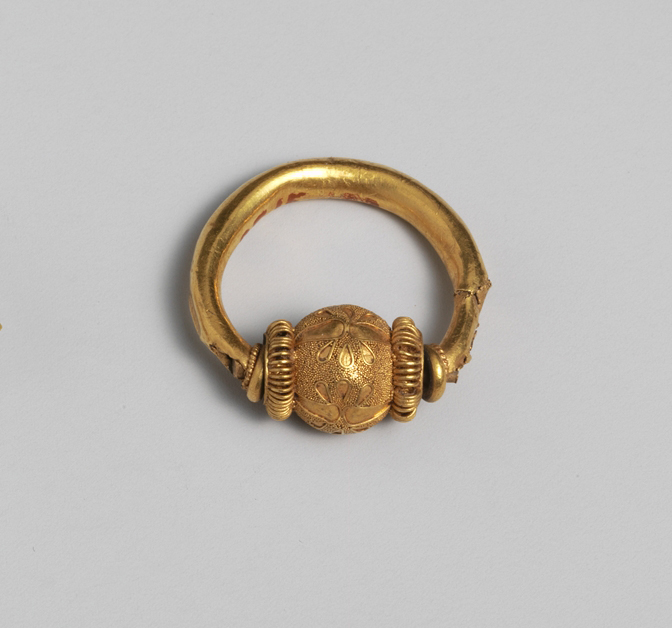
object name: ring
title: Gold ring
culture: etruscan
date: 400-201 BCE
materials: gold